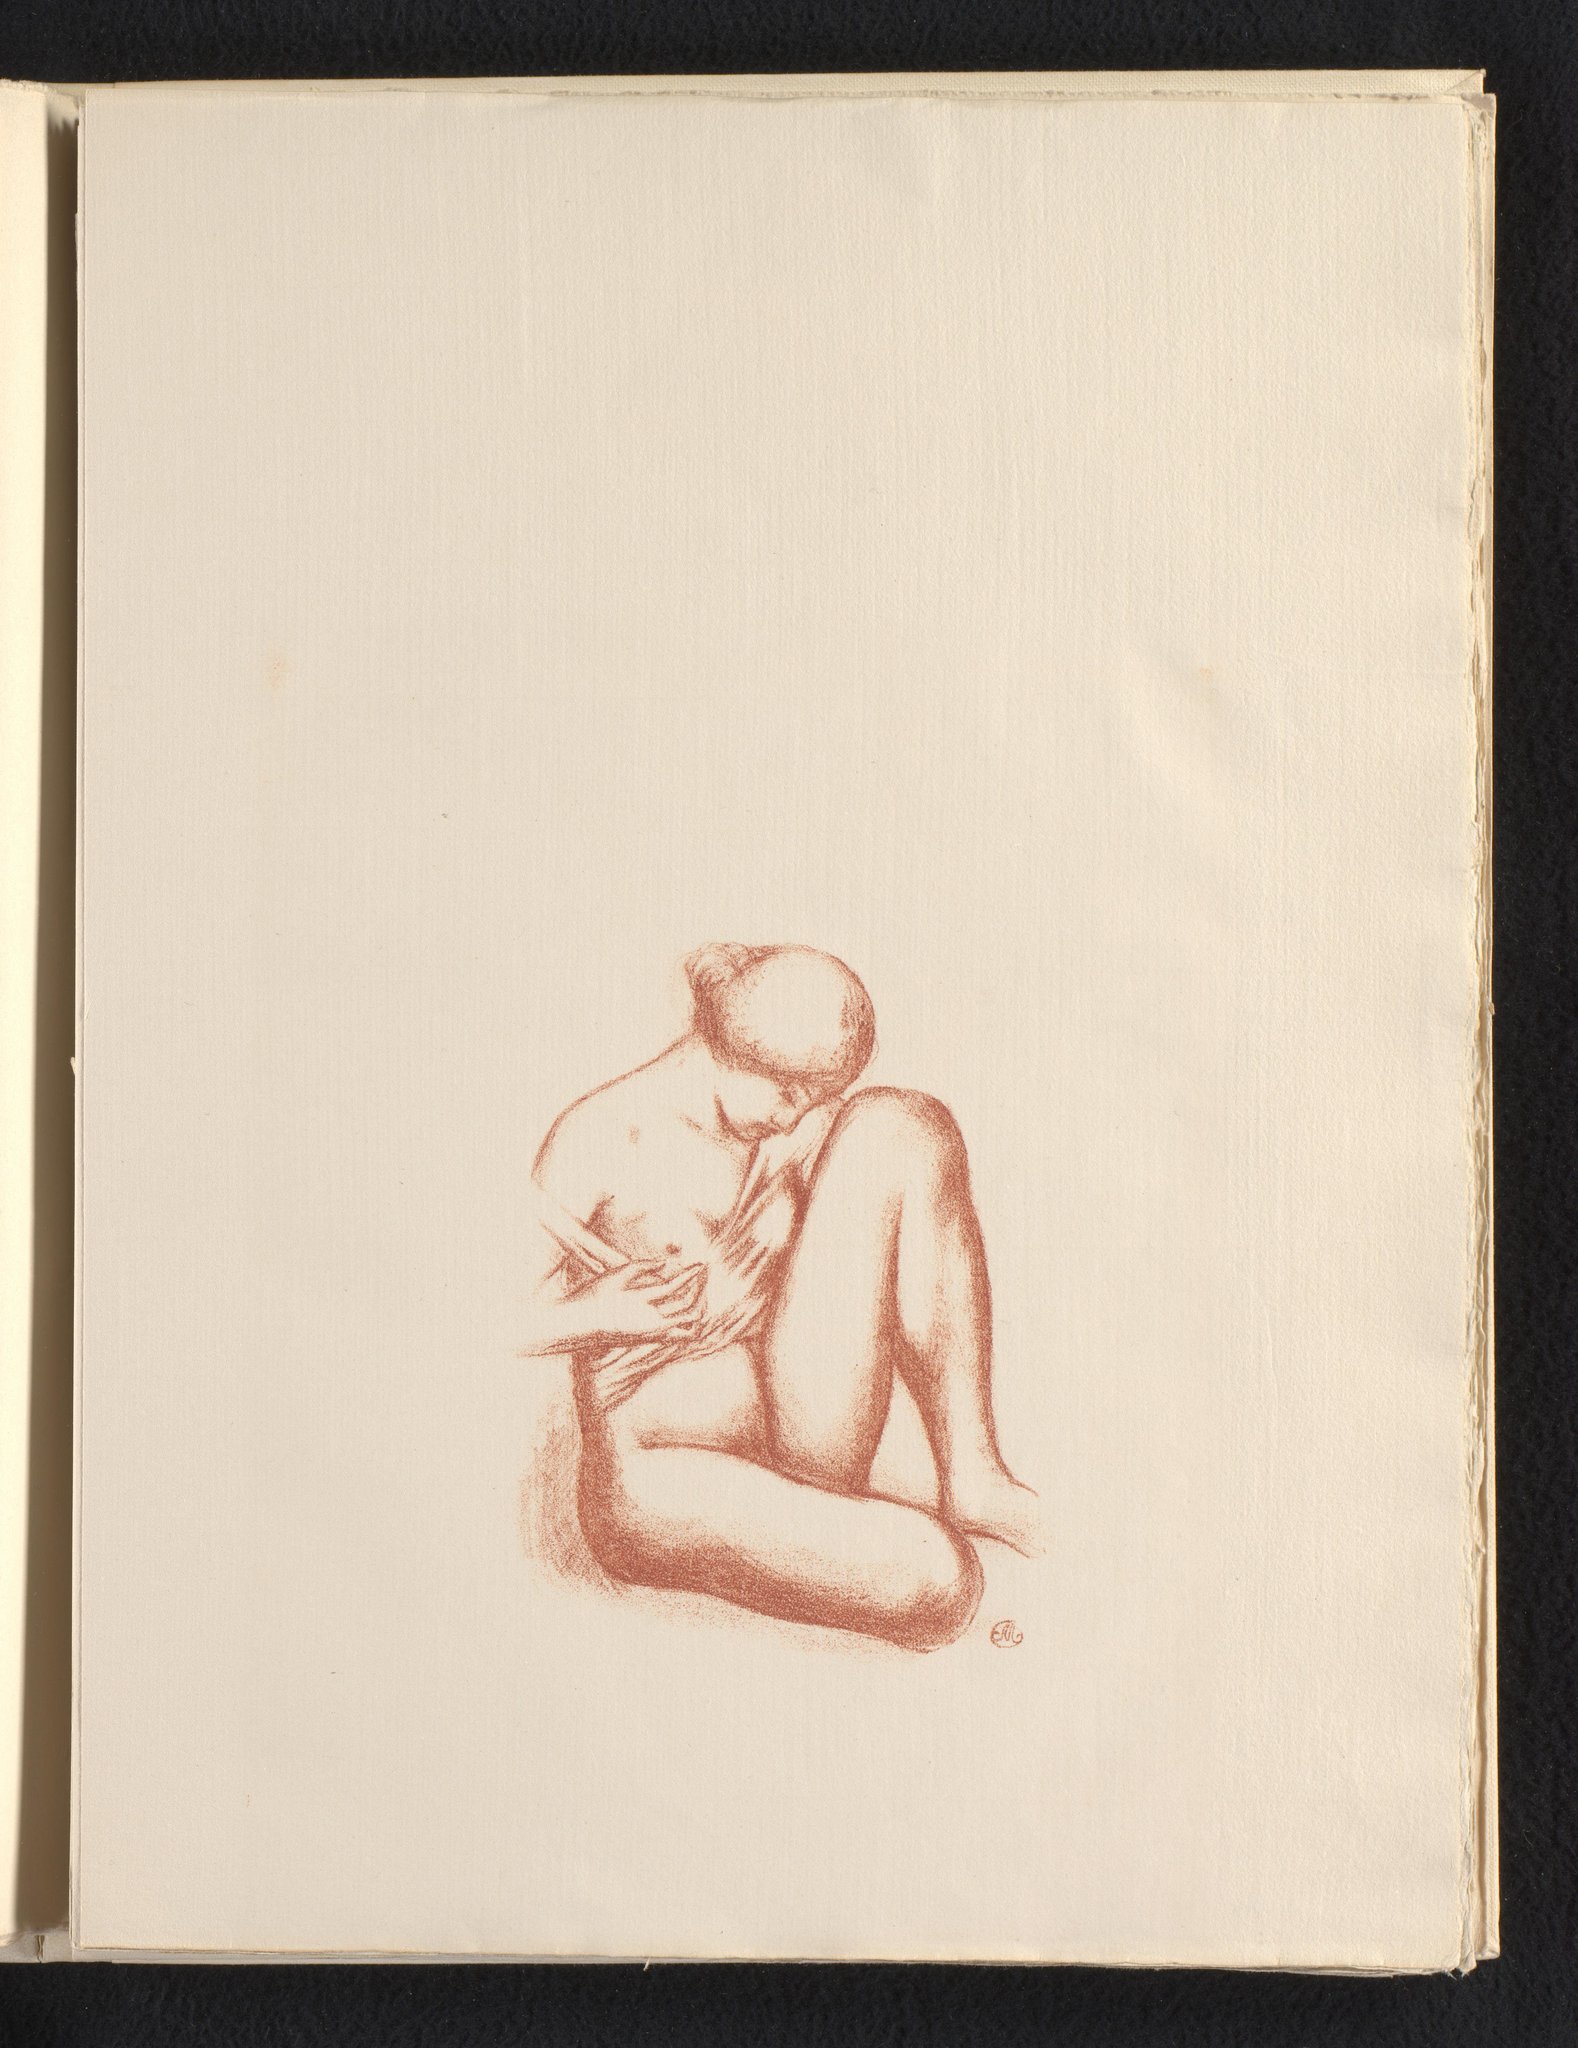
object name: page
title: Zittende naakte vrouw met ontbloot onderlijf en een ontblote borst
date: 1948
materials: paper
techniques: lithograph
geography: paris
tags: sitting figure - aa - female human figure, woman (showing herself) undressed, quasi-nude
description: Prent uit: Lucianus van Samosata. Dialogues des Courtisanes. [Vertaald uit het Grieks door] Charles Astruc. Parijs: s.n., 1948, deel van de suite met een extra afdruk van de prenten in sanguine.